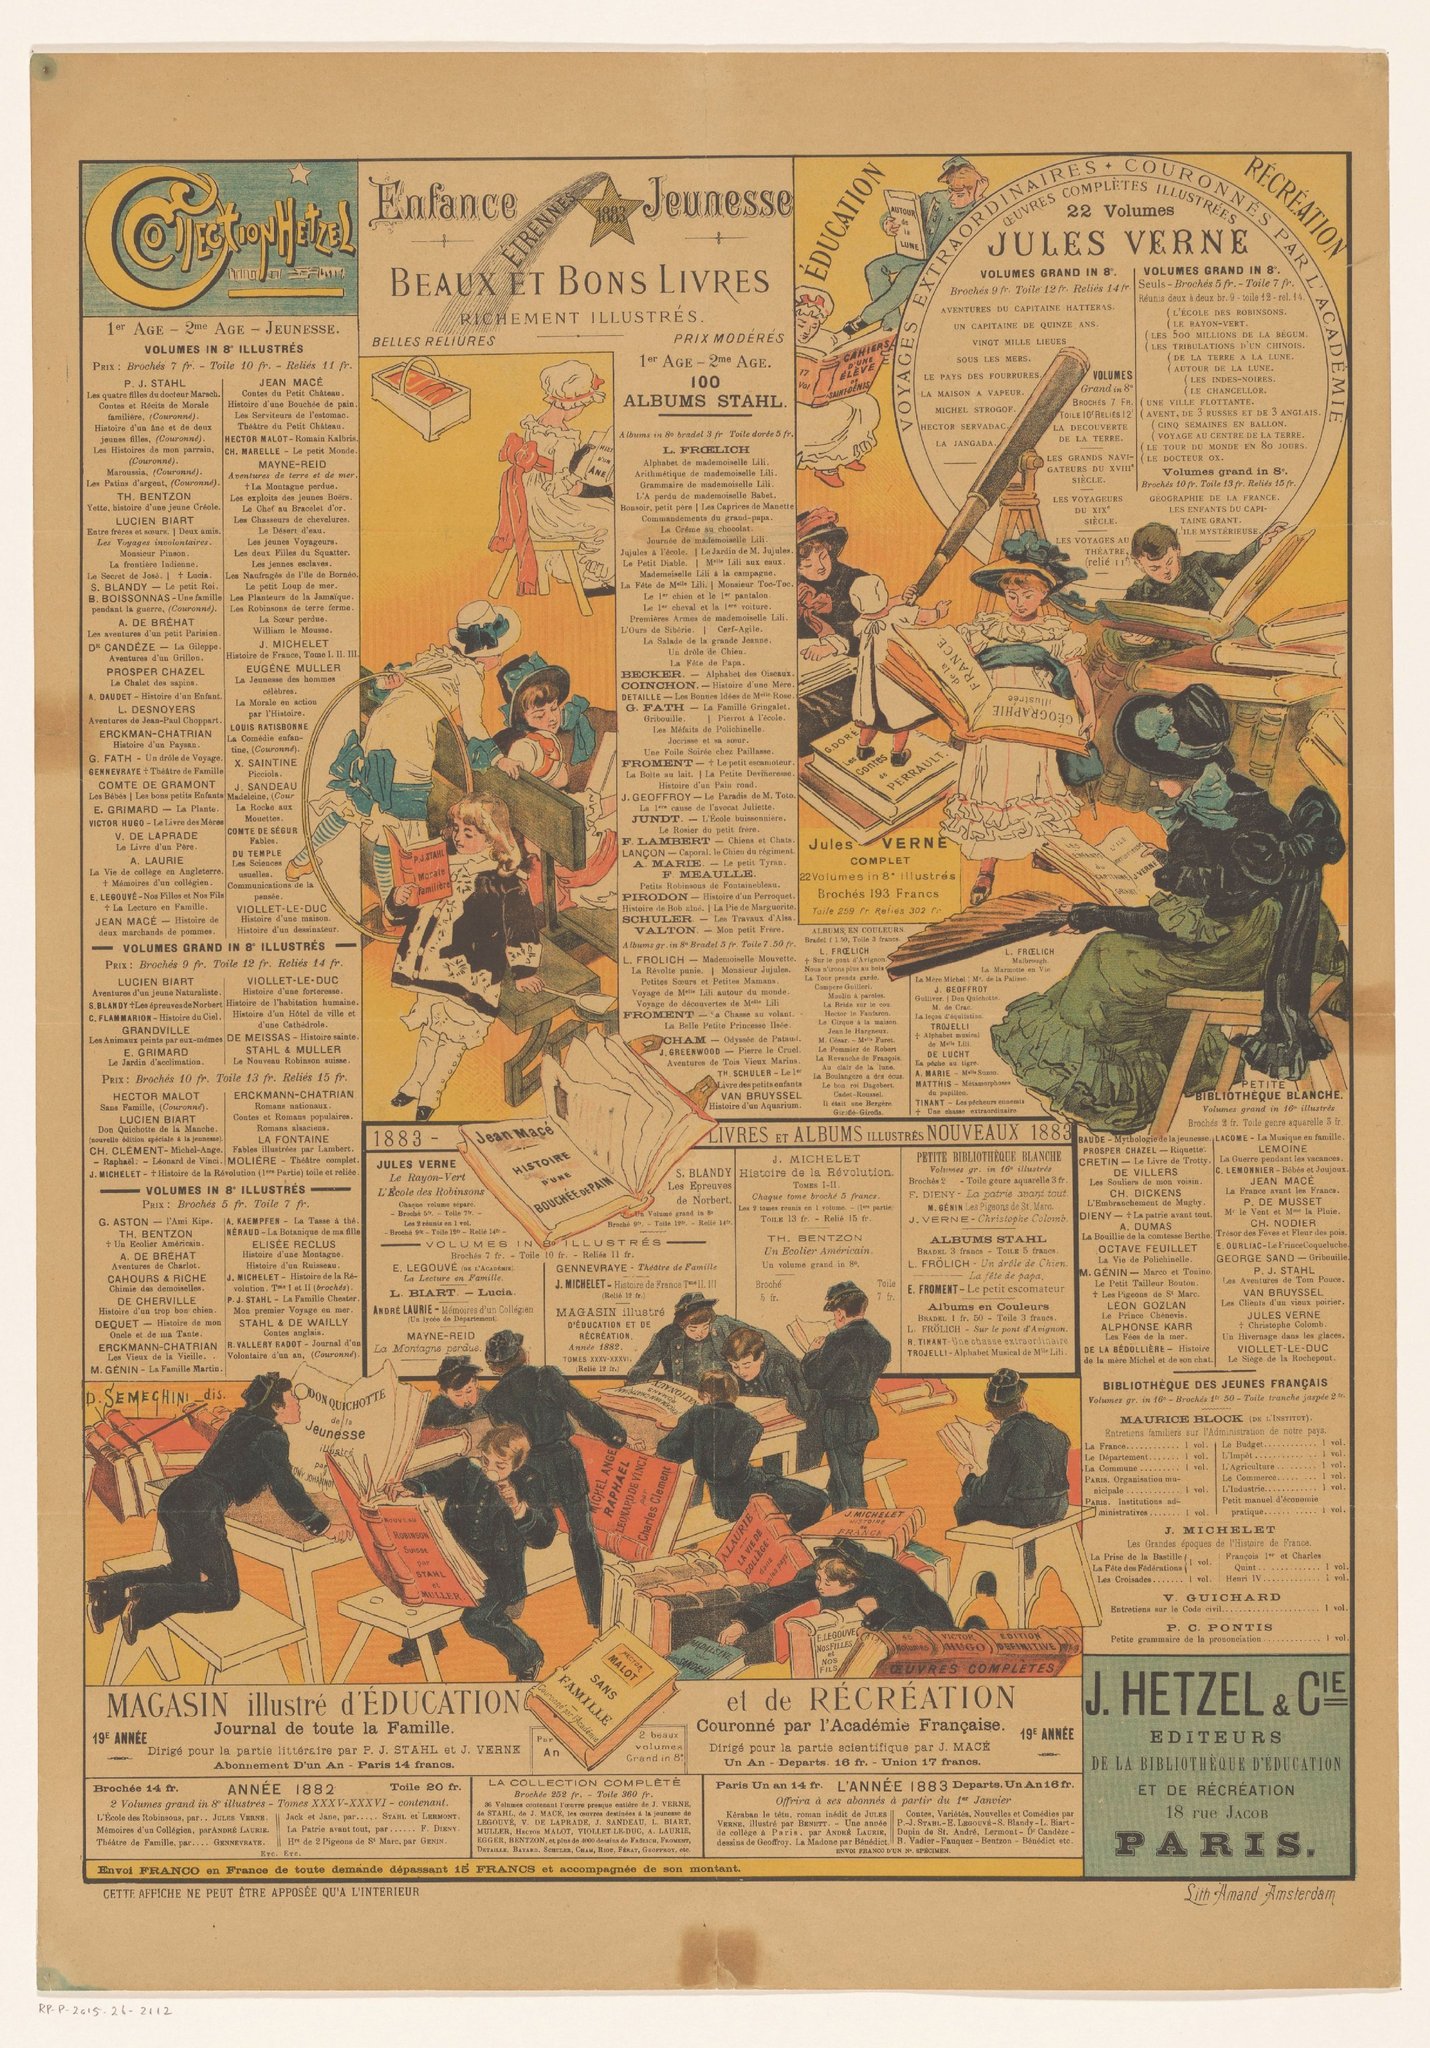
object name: poster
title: Fondslijst van J. Hetzel & Cie te Parijs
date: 1883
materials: paper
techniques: lithograph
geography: amsterdam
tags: reading, children's books, book, telescope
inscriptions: collector's mark: Lugt 2228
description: Tekst met illustraties van kinderen en jonge soldaten die lezen in werken uitgeven door Hetzel. Rechtsboven kijkt een klein kind door een telescoop, staand op een stapel boeken. Tekst op verso.